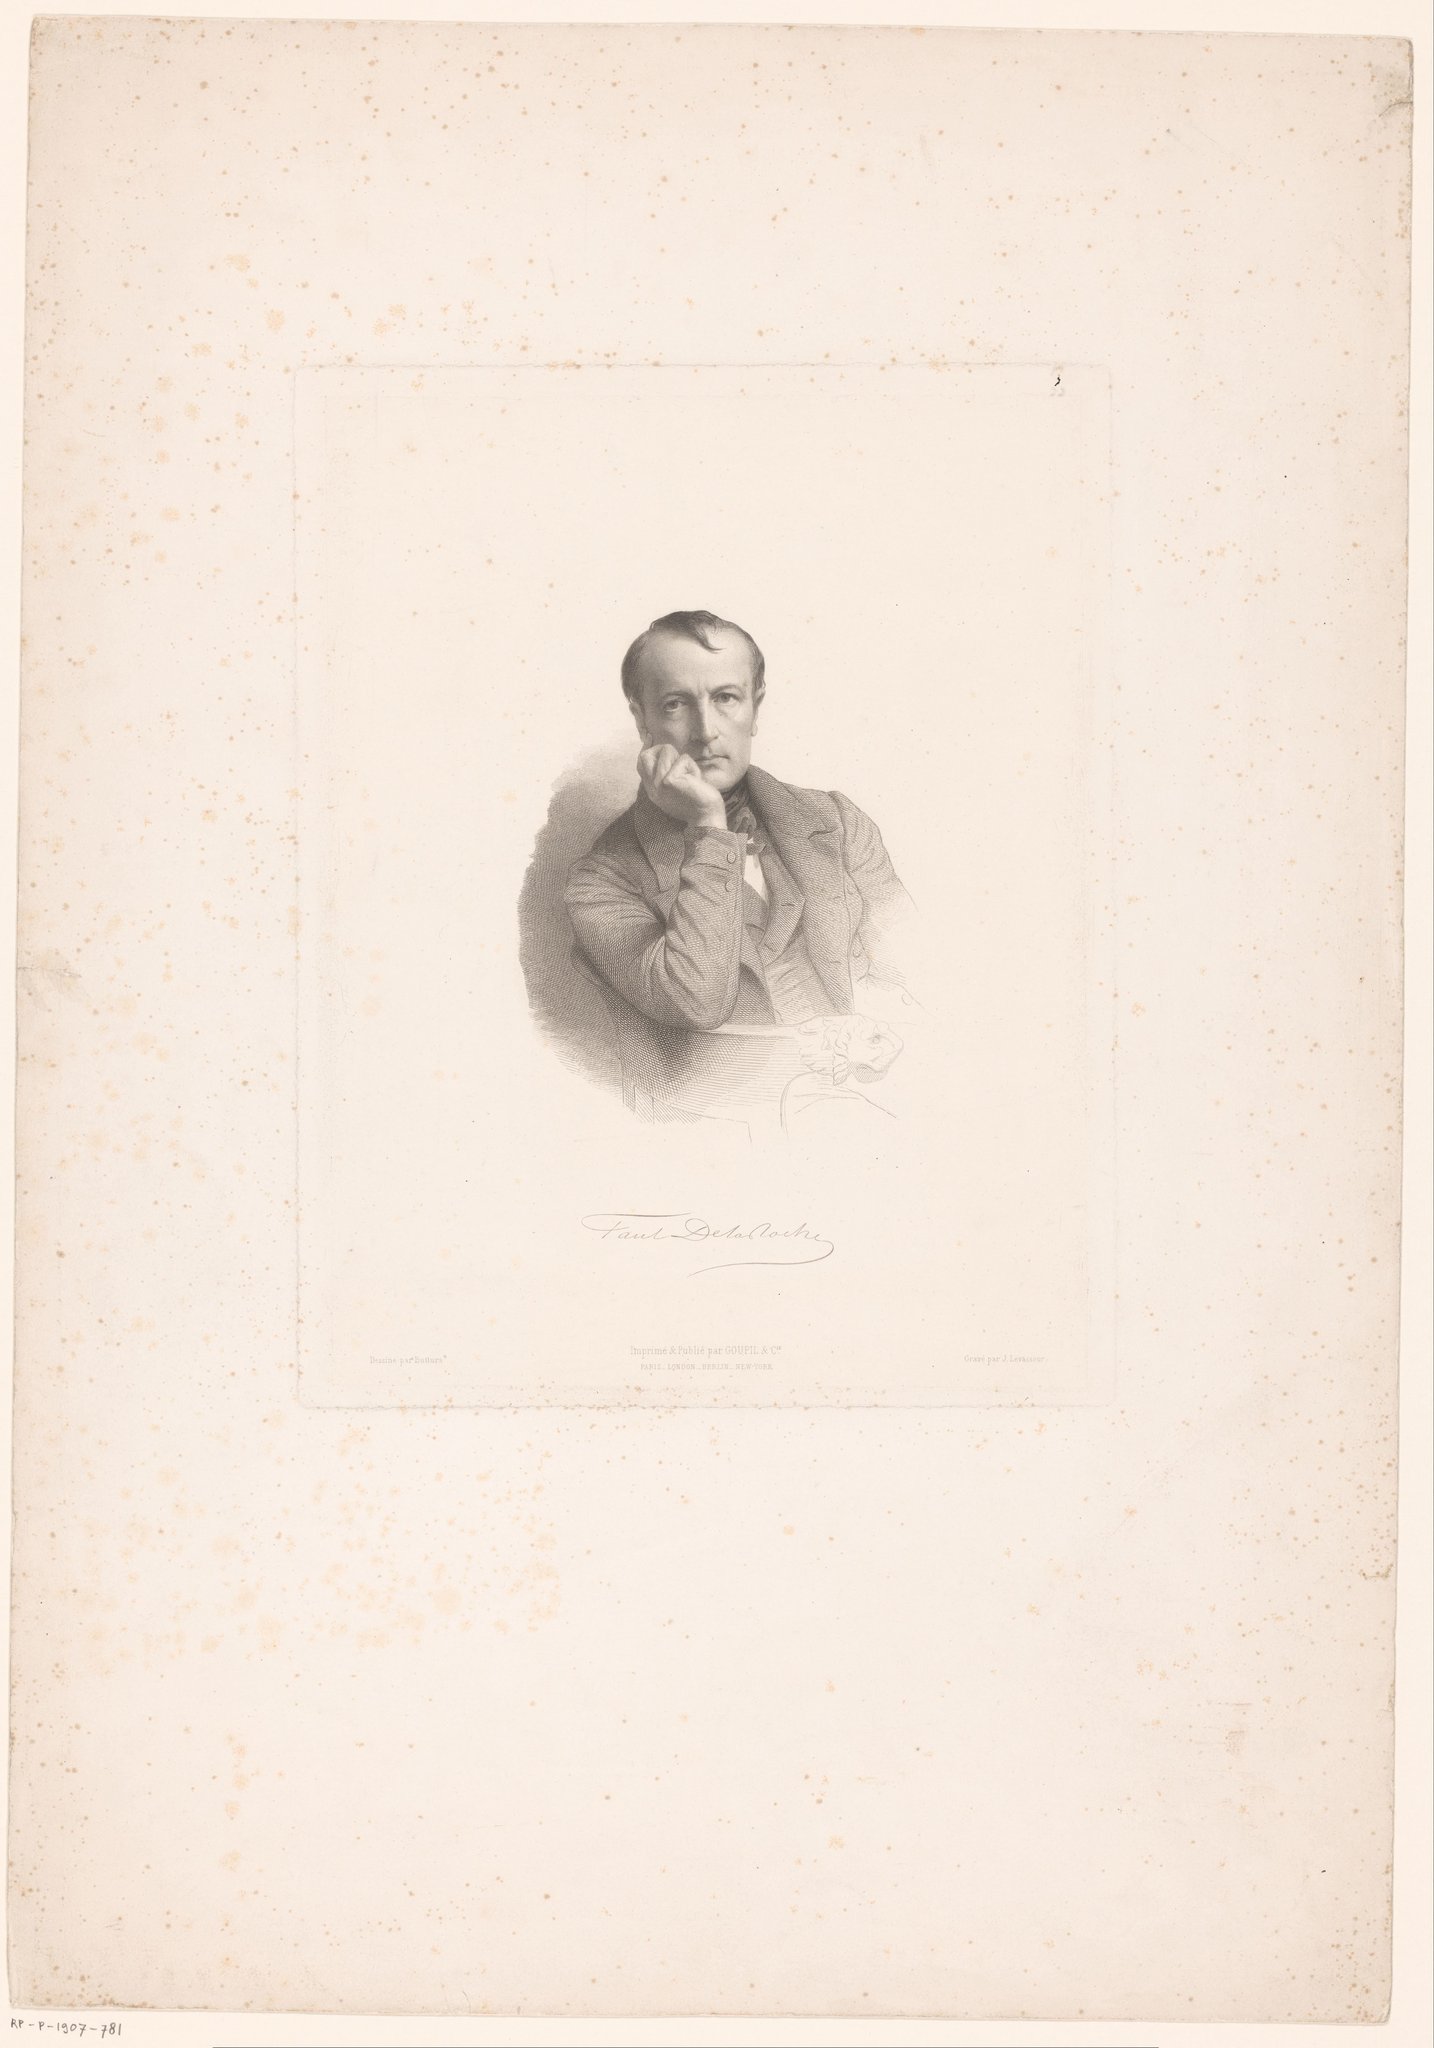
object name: print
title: Portret van Paul Delaroche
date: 1853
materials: paper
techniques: engraving, etching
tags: paris, painter, draughtsman, sculptor, paul delaroche, historical persons, portrait, self-portrait of artist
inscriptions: collector's mark: Lugt 2228